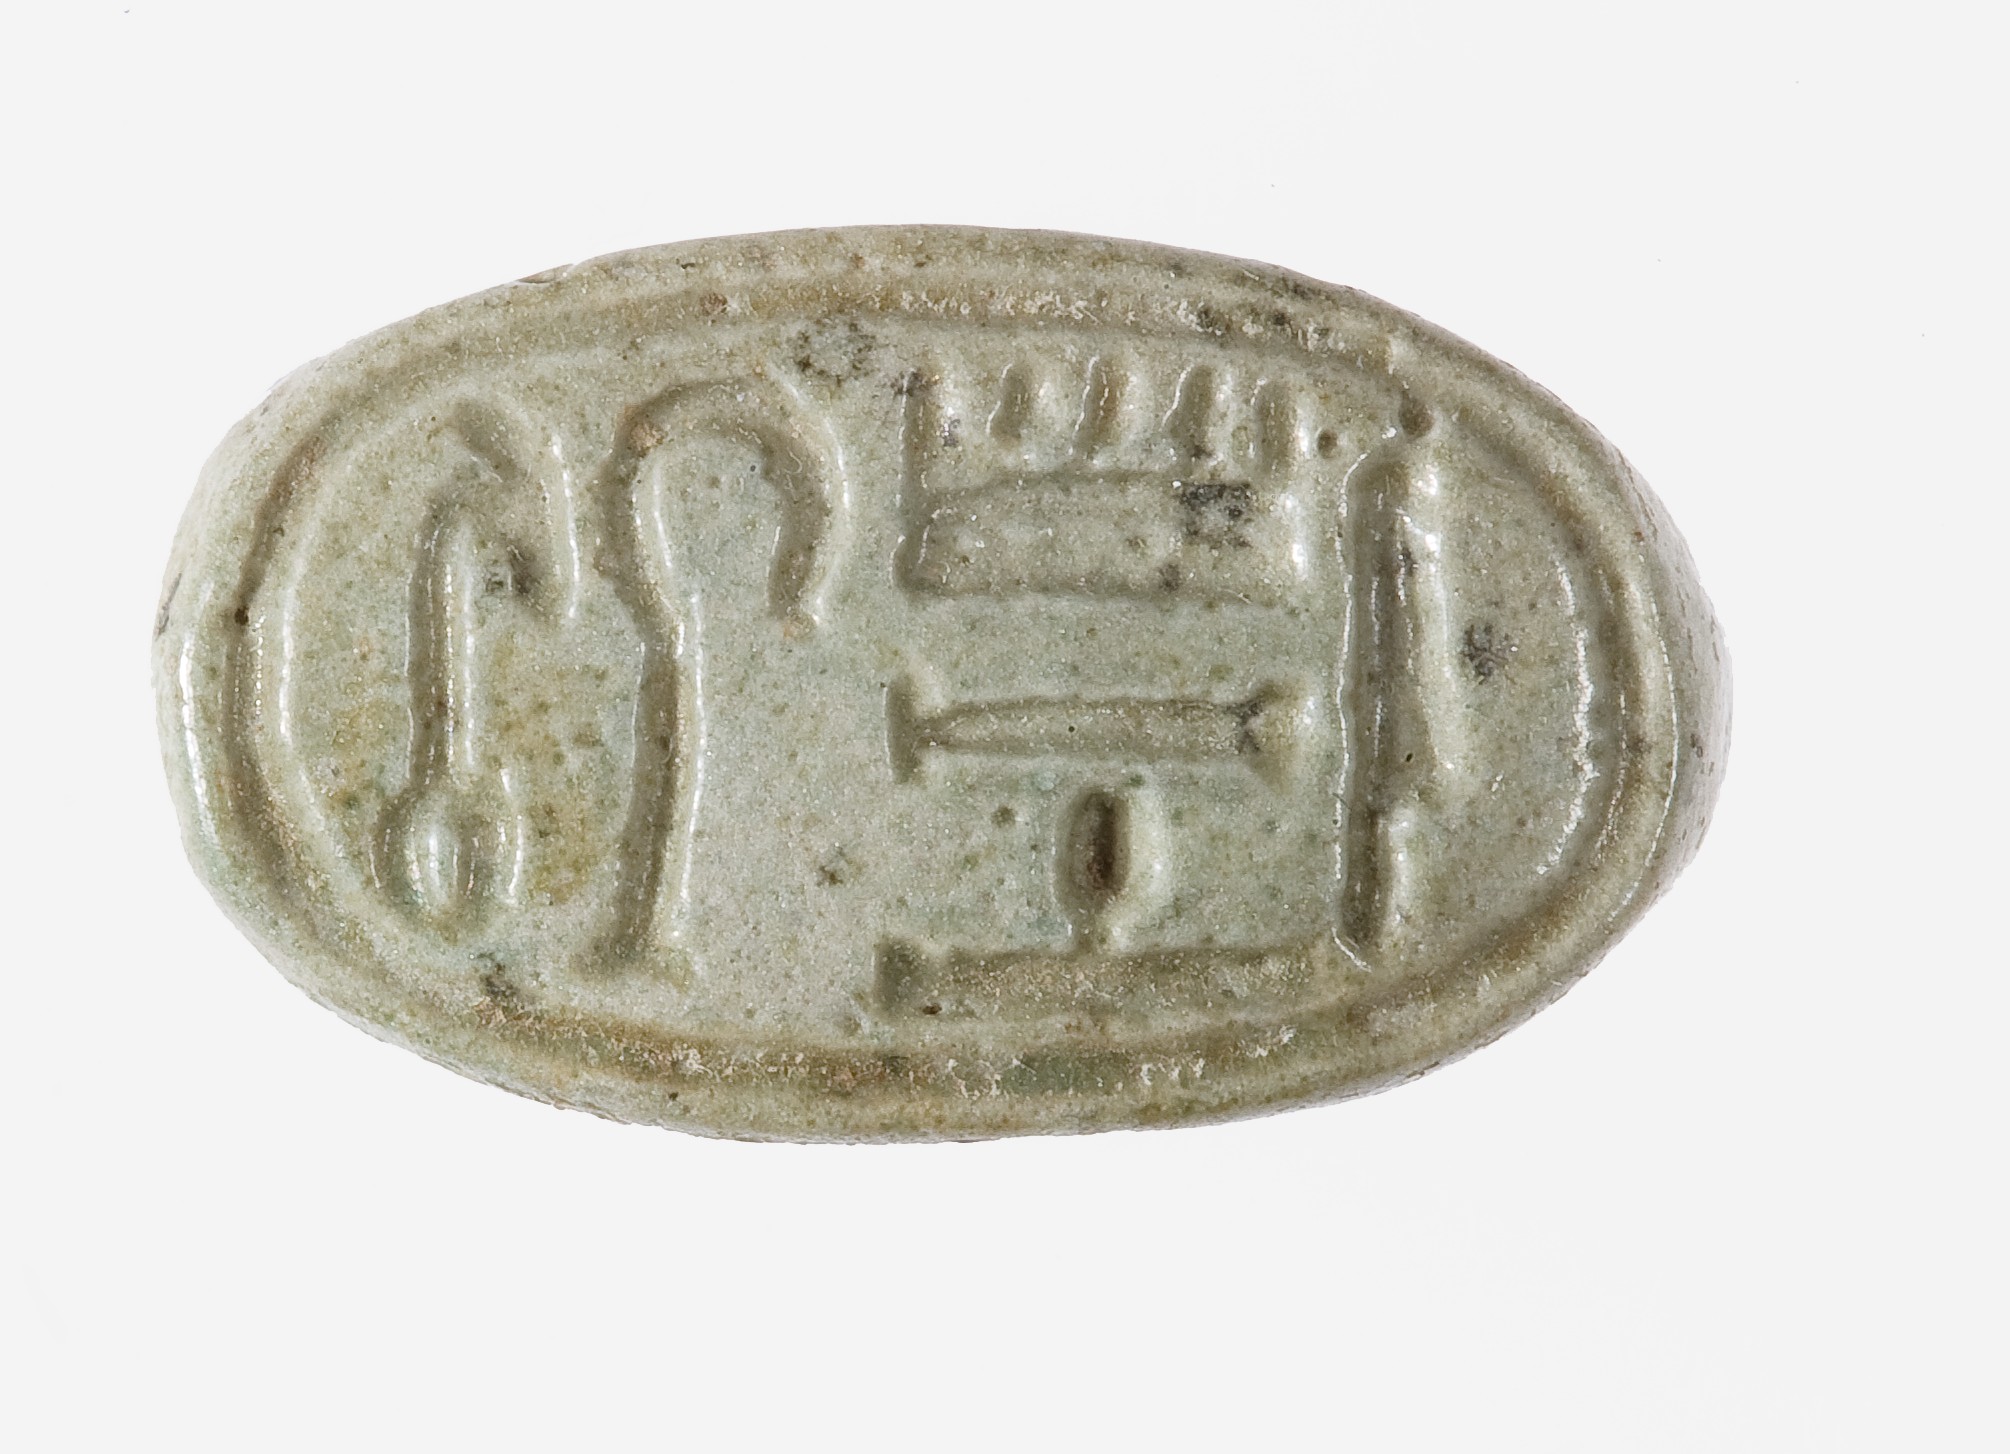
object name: ring, amenhotep iii, ruler of thebe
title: Ring Inscribed Amenhotep Ruler of Thebes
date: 1390-1352 BCE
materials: faience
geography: egypt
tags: hieroglyphs